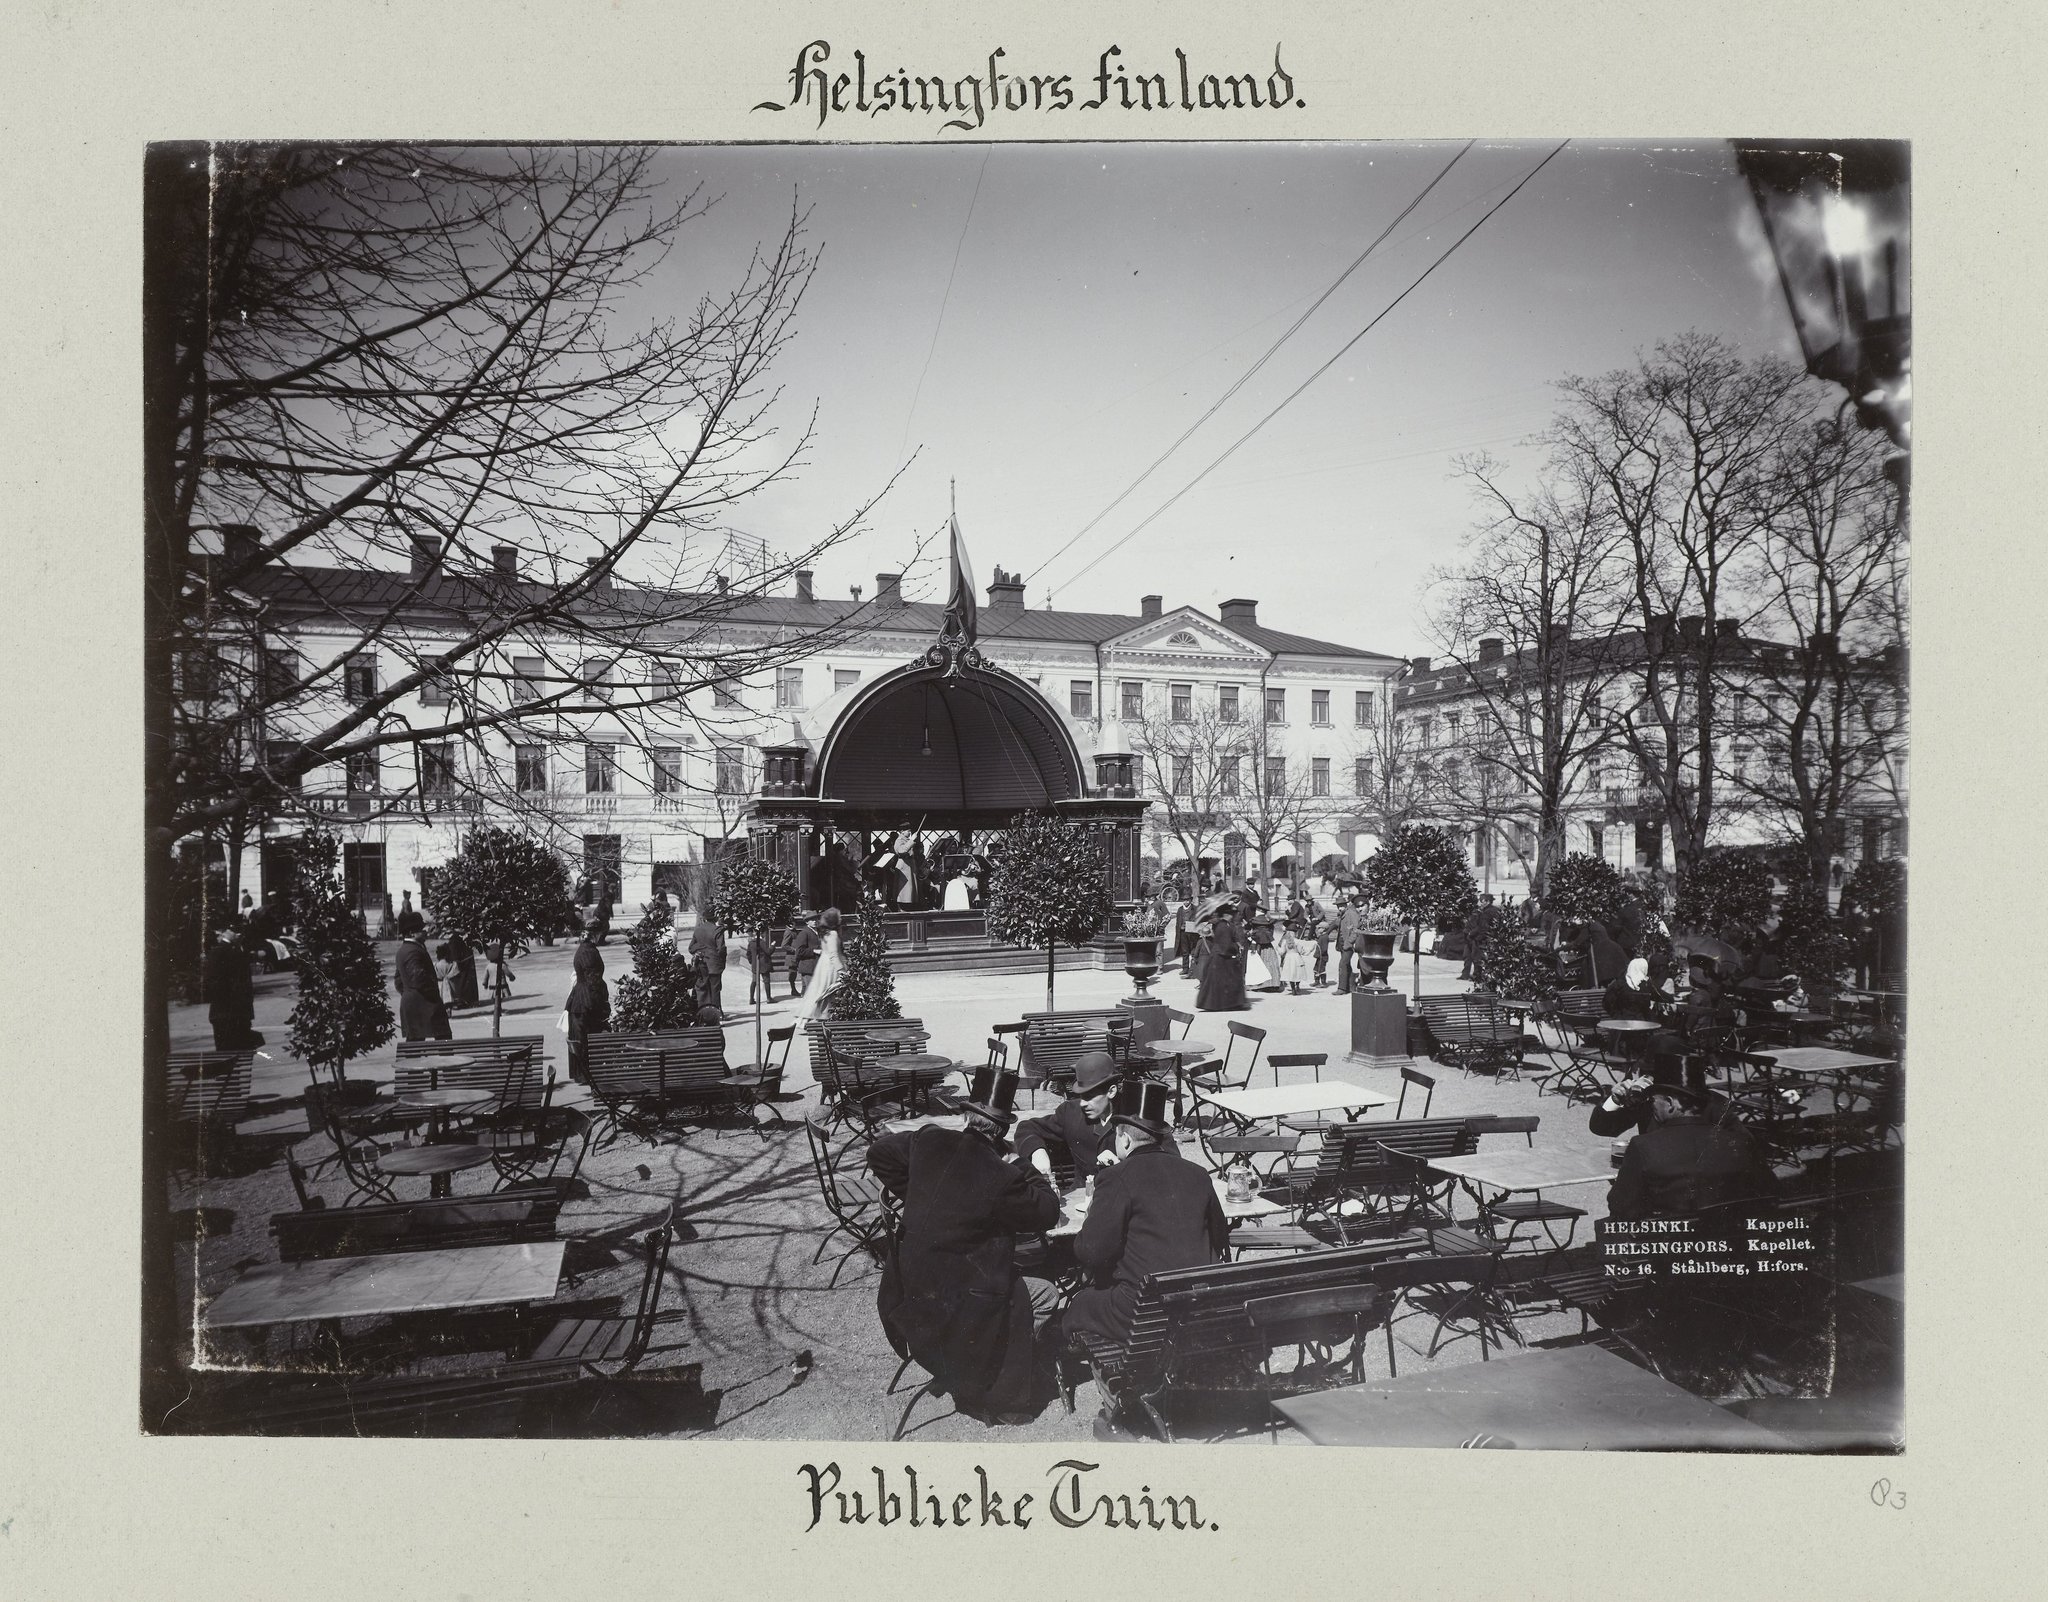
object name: photograph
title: Helsinki Kappeli No 16 Stahlberg, H'fors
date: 1893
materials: paper, photographic support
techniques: albumen print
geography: helsinki